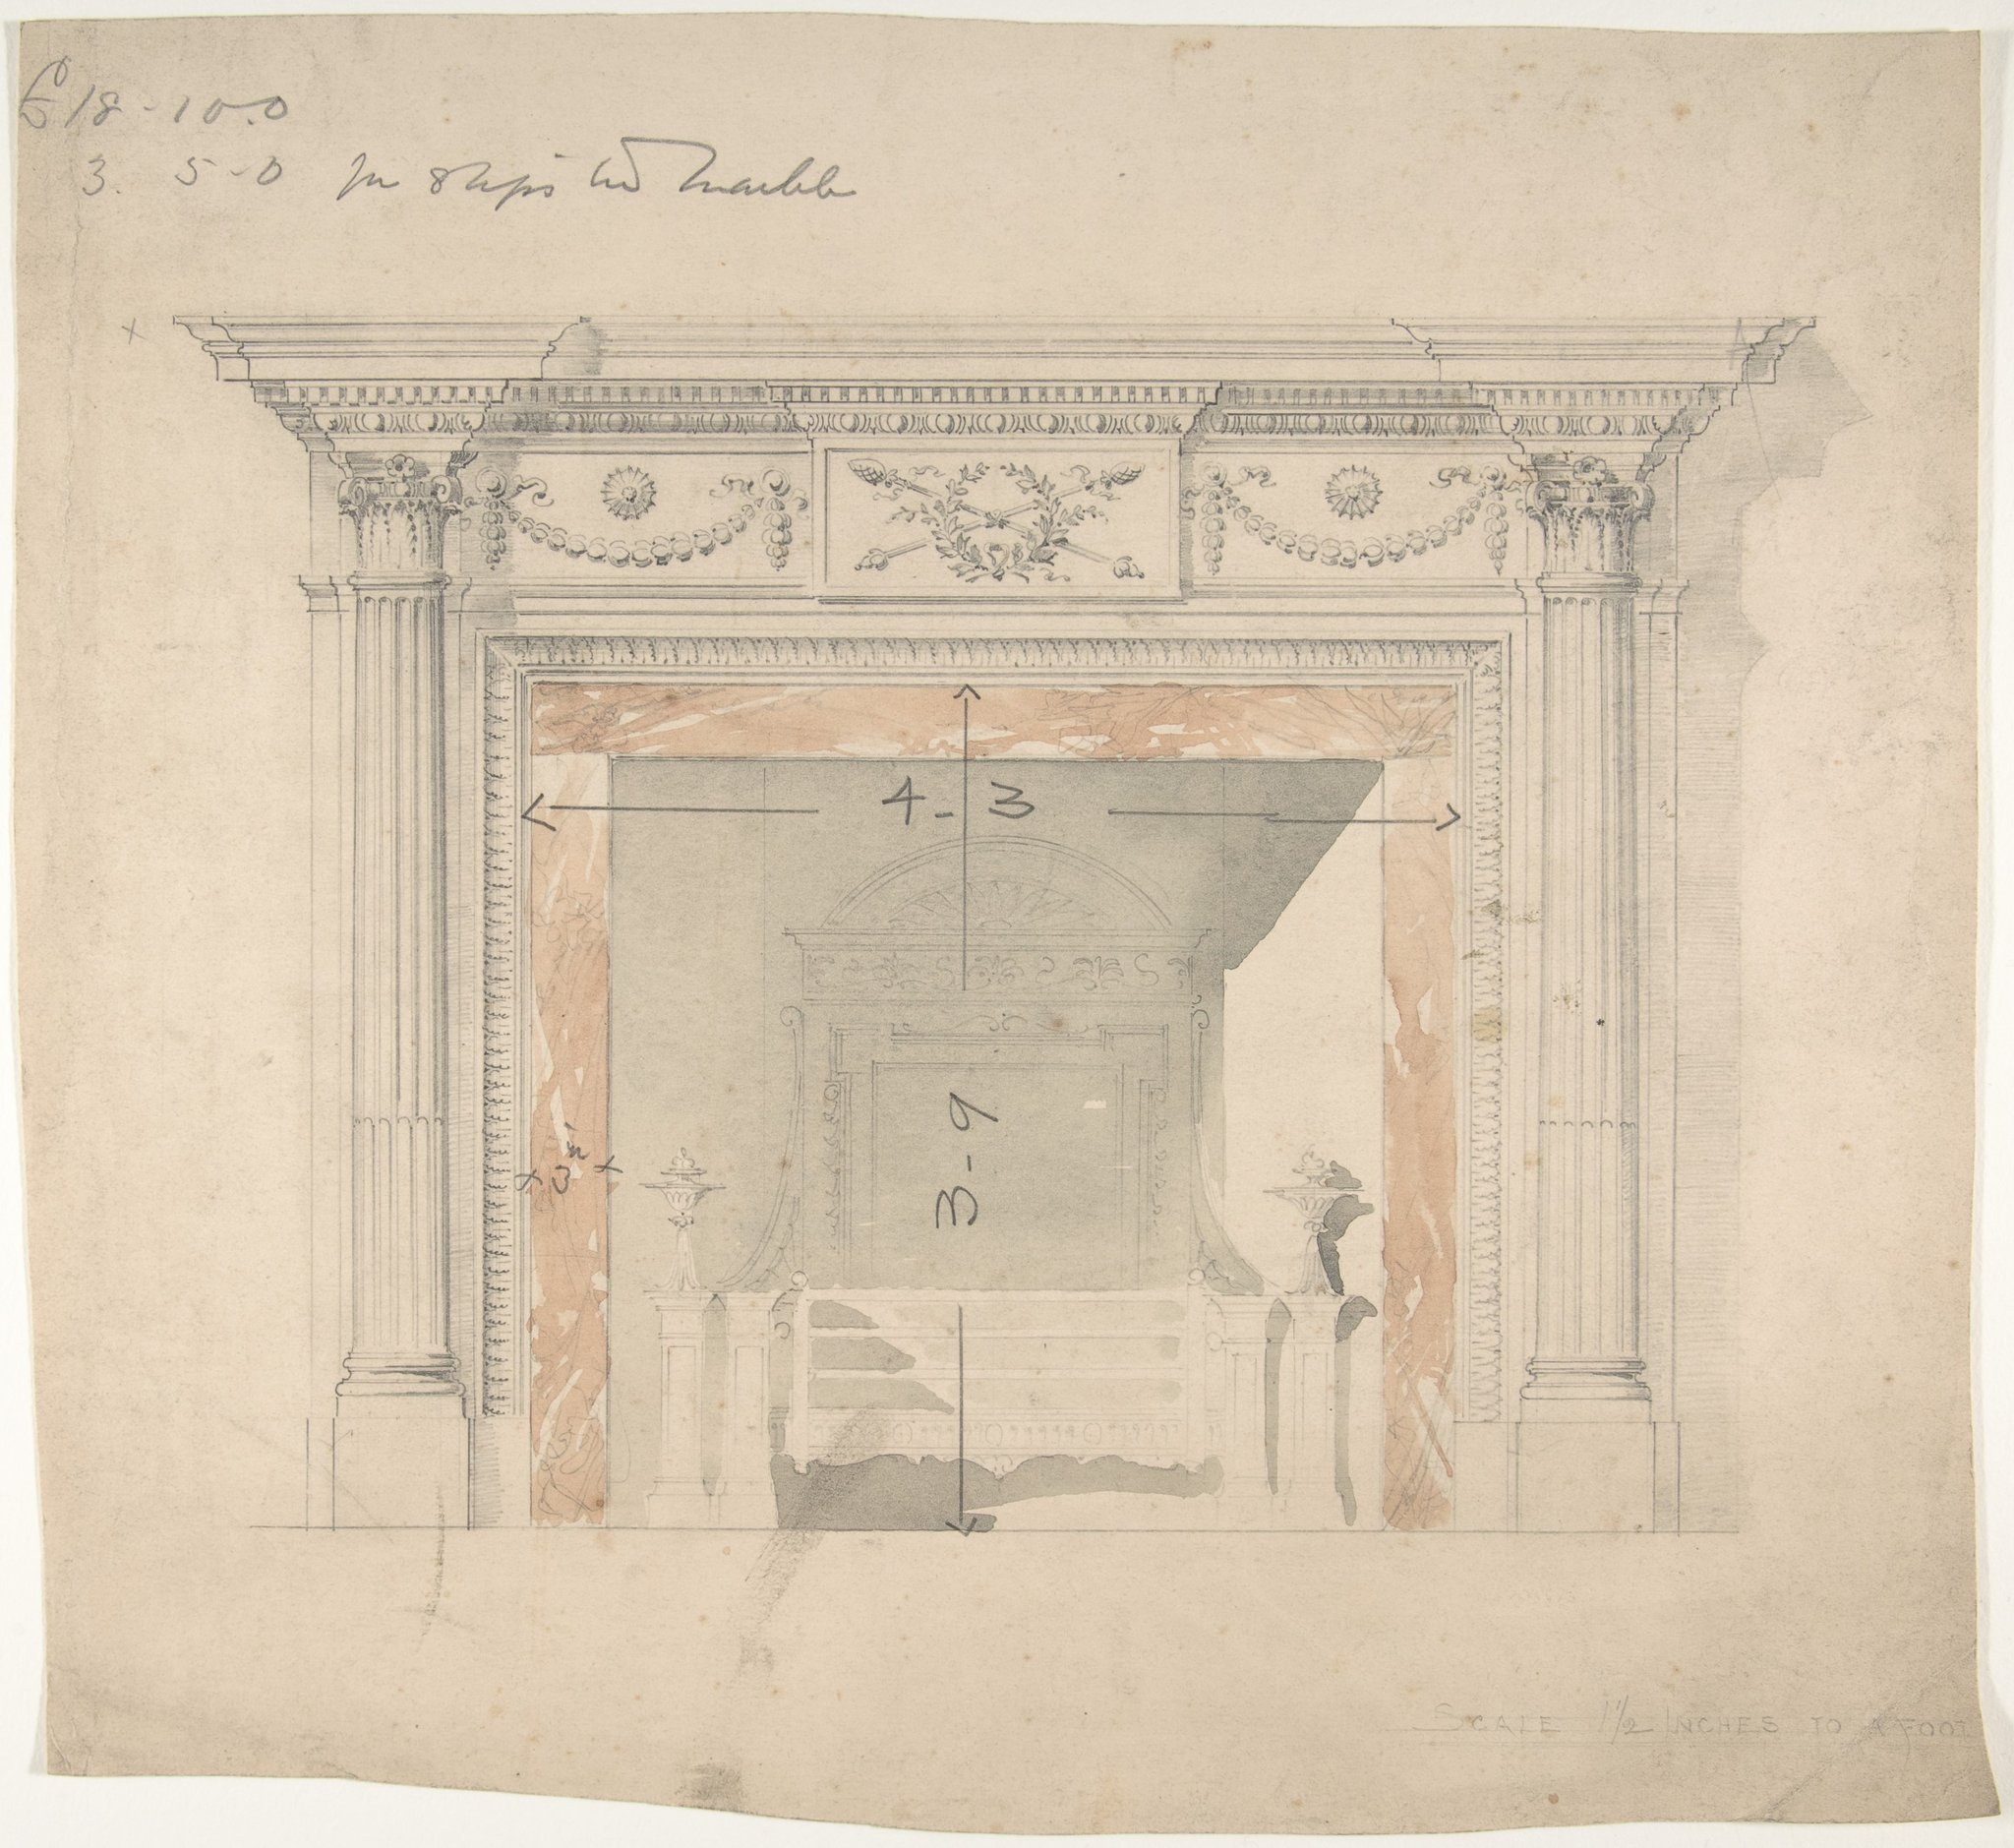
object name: drawing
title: Design for an Adam-style Mantel, with a Marble Surround and Iron Firebox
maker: anonymous, british, late 18th–early 19th century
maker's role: artist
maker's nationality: british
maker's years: 1771-1835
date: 1767-1833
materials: graphite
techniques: brush, wash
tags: fireplaces